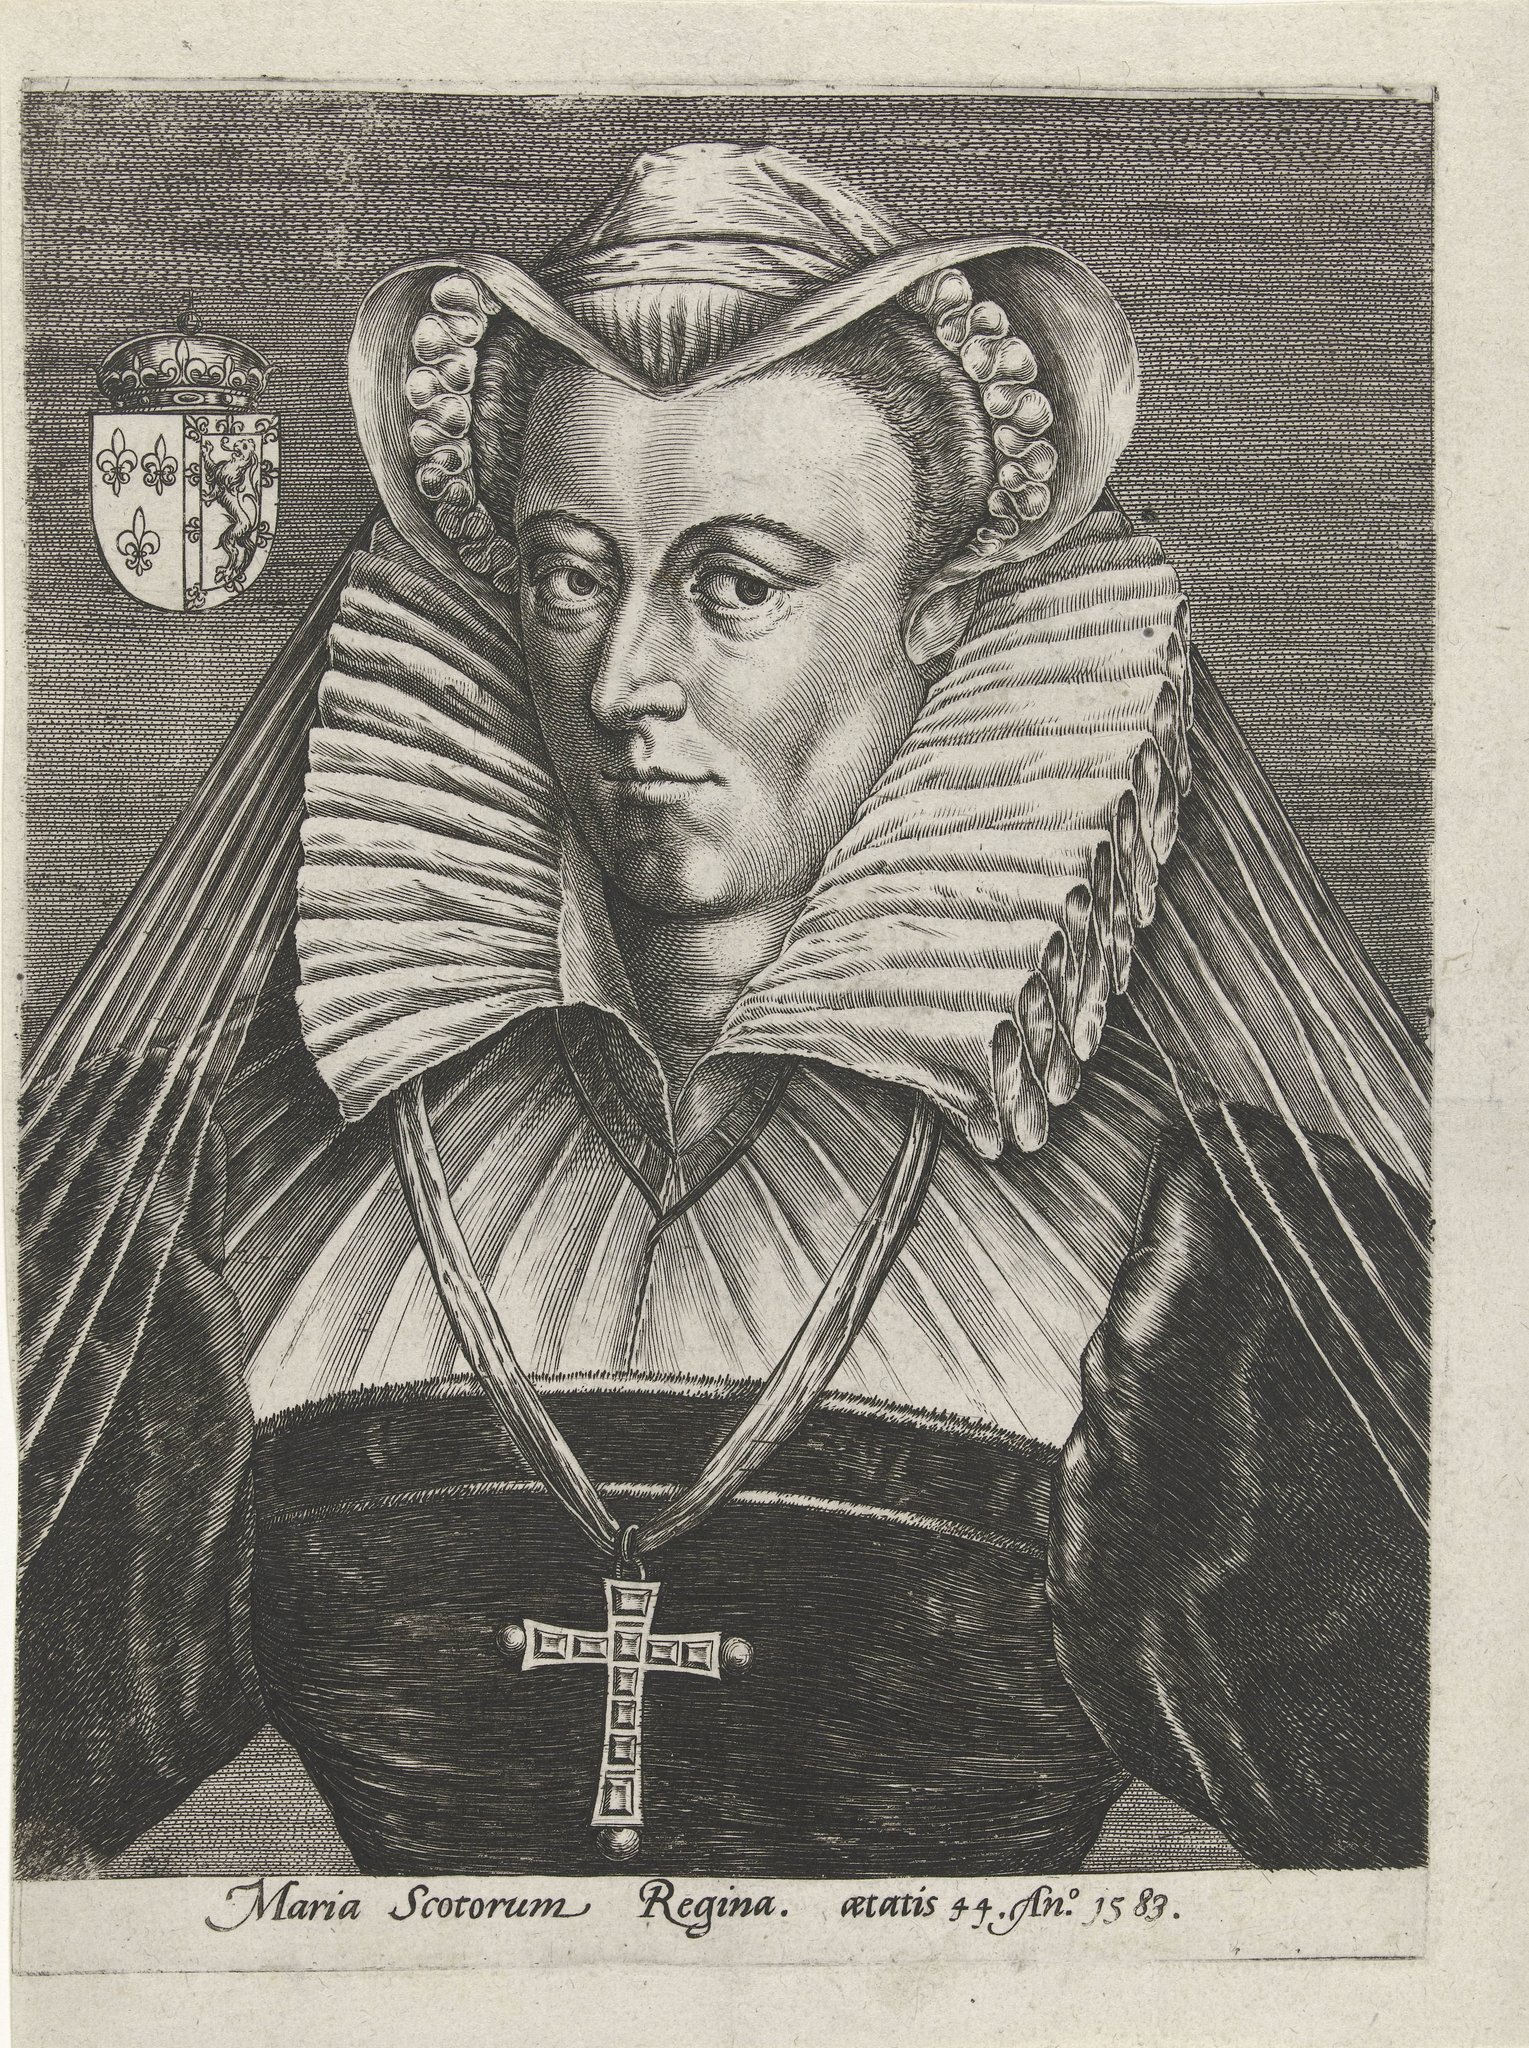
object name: print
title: Maria Scotorum Regina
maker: Anonymous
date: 1605-1652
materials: paper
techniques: engraving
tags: historical persons - bb - woman, crucifix ~ personal devotion, armorial bearing, heraldry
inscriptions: inscription: ‘K.B.’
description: Busteportret van Maria I Stuart, koningin van Schotland, naar links met een kruis aan een halssnoer op haar borst. Links haar wapen.